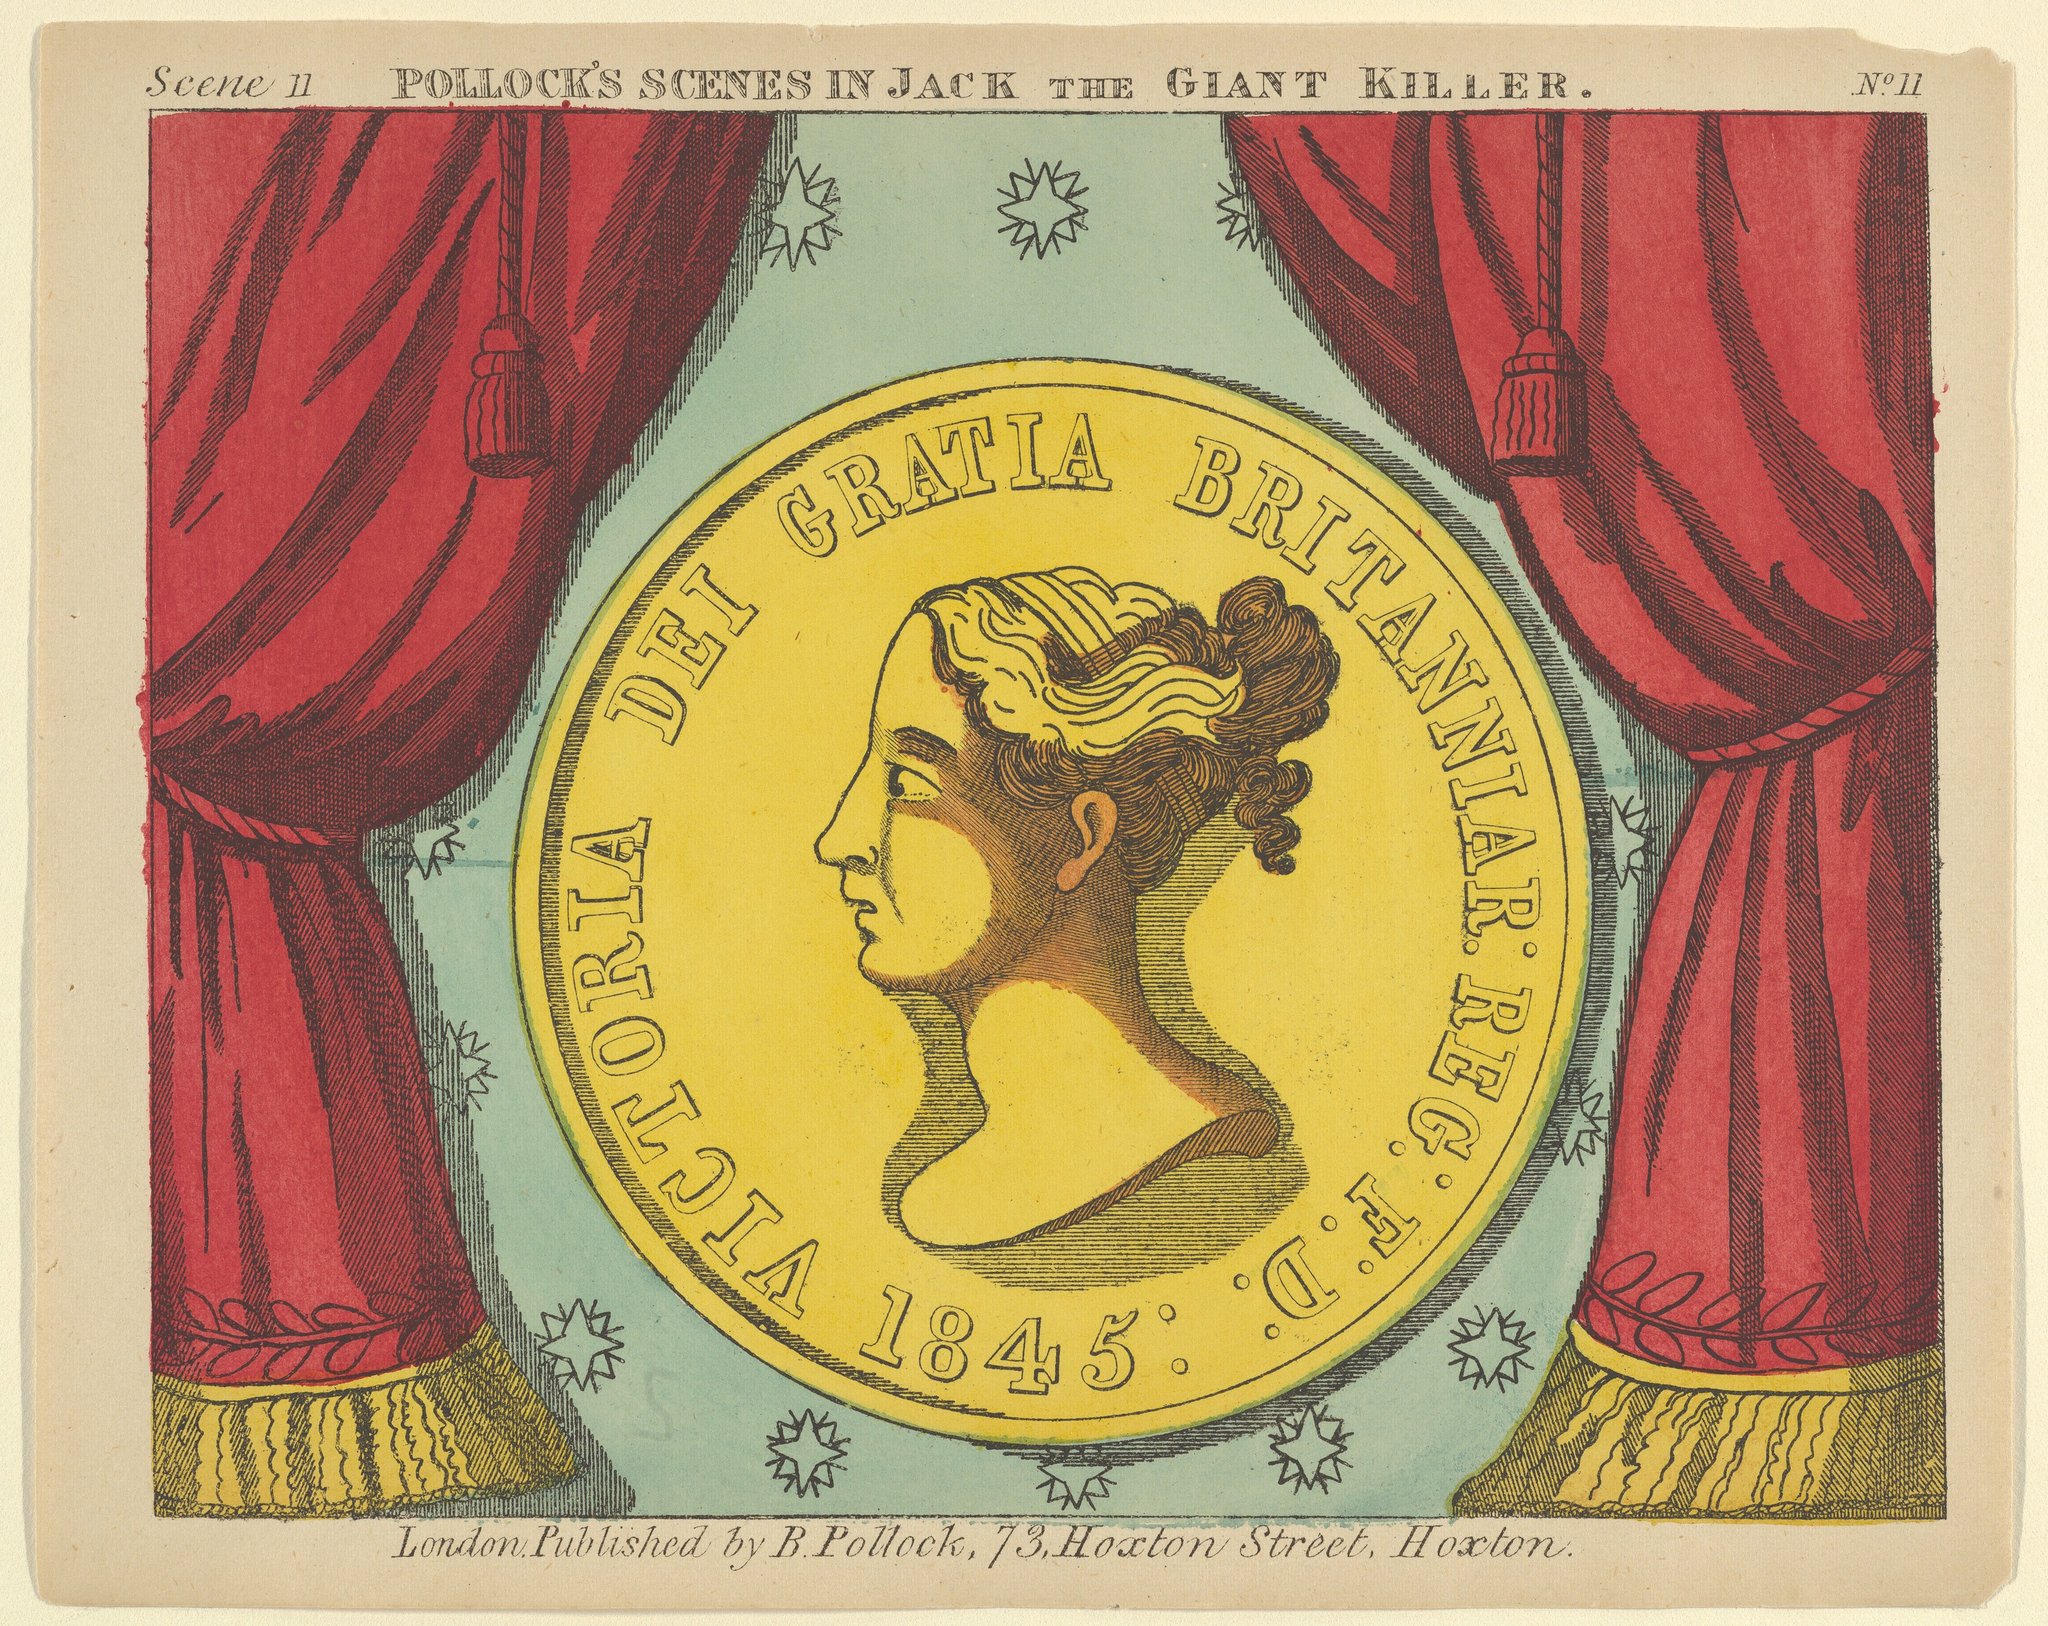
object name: print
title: Scene 11, from Jack and the Giant Killer, Scenes for a Toy Theater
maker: benjamin pollock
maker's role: publisher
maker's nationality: british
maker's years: 1857-1937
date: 1870-1890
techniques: lithograph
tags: profiles,women,norse mythology